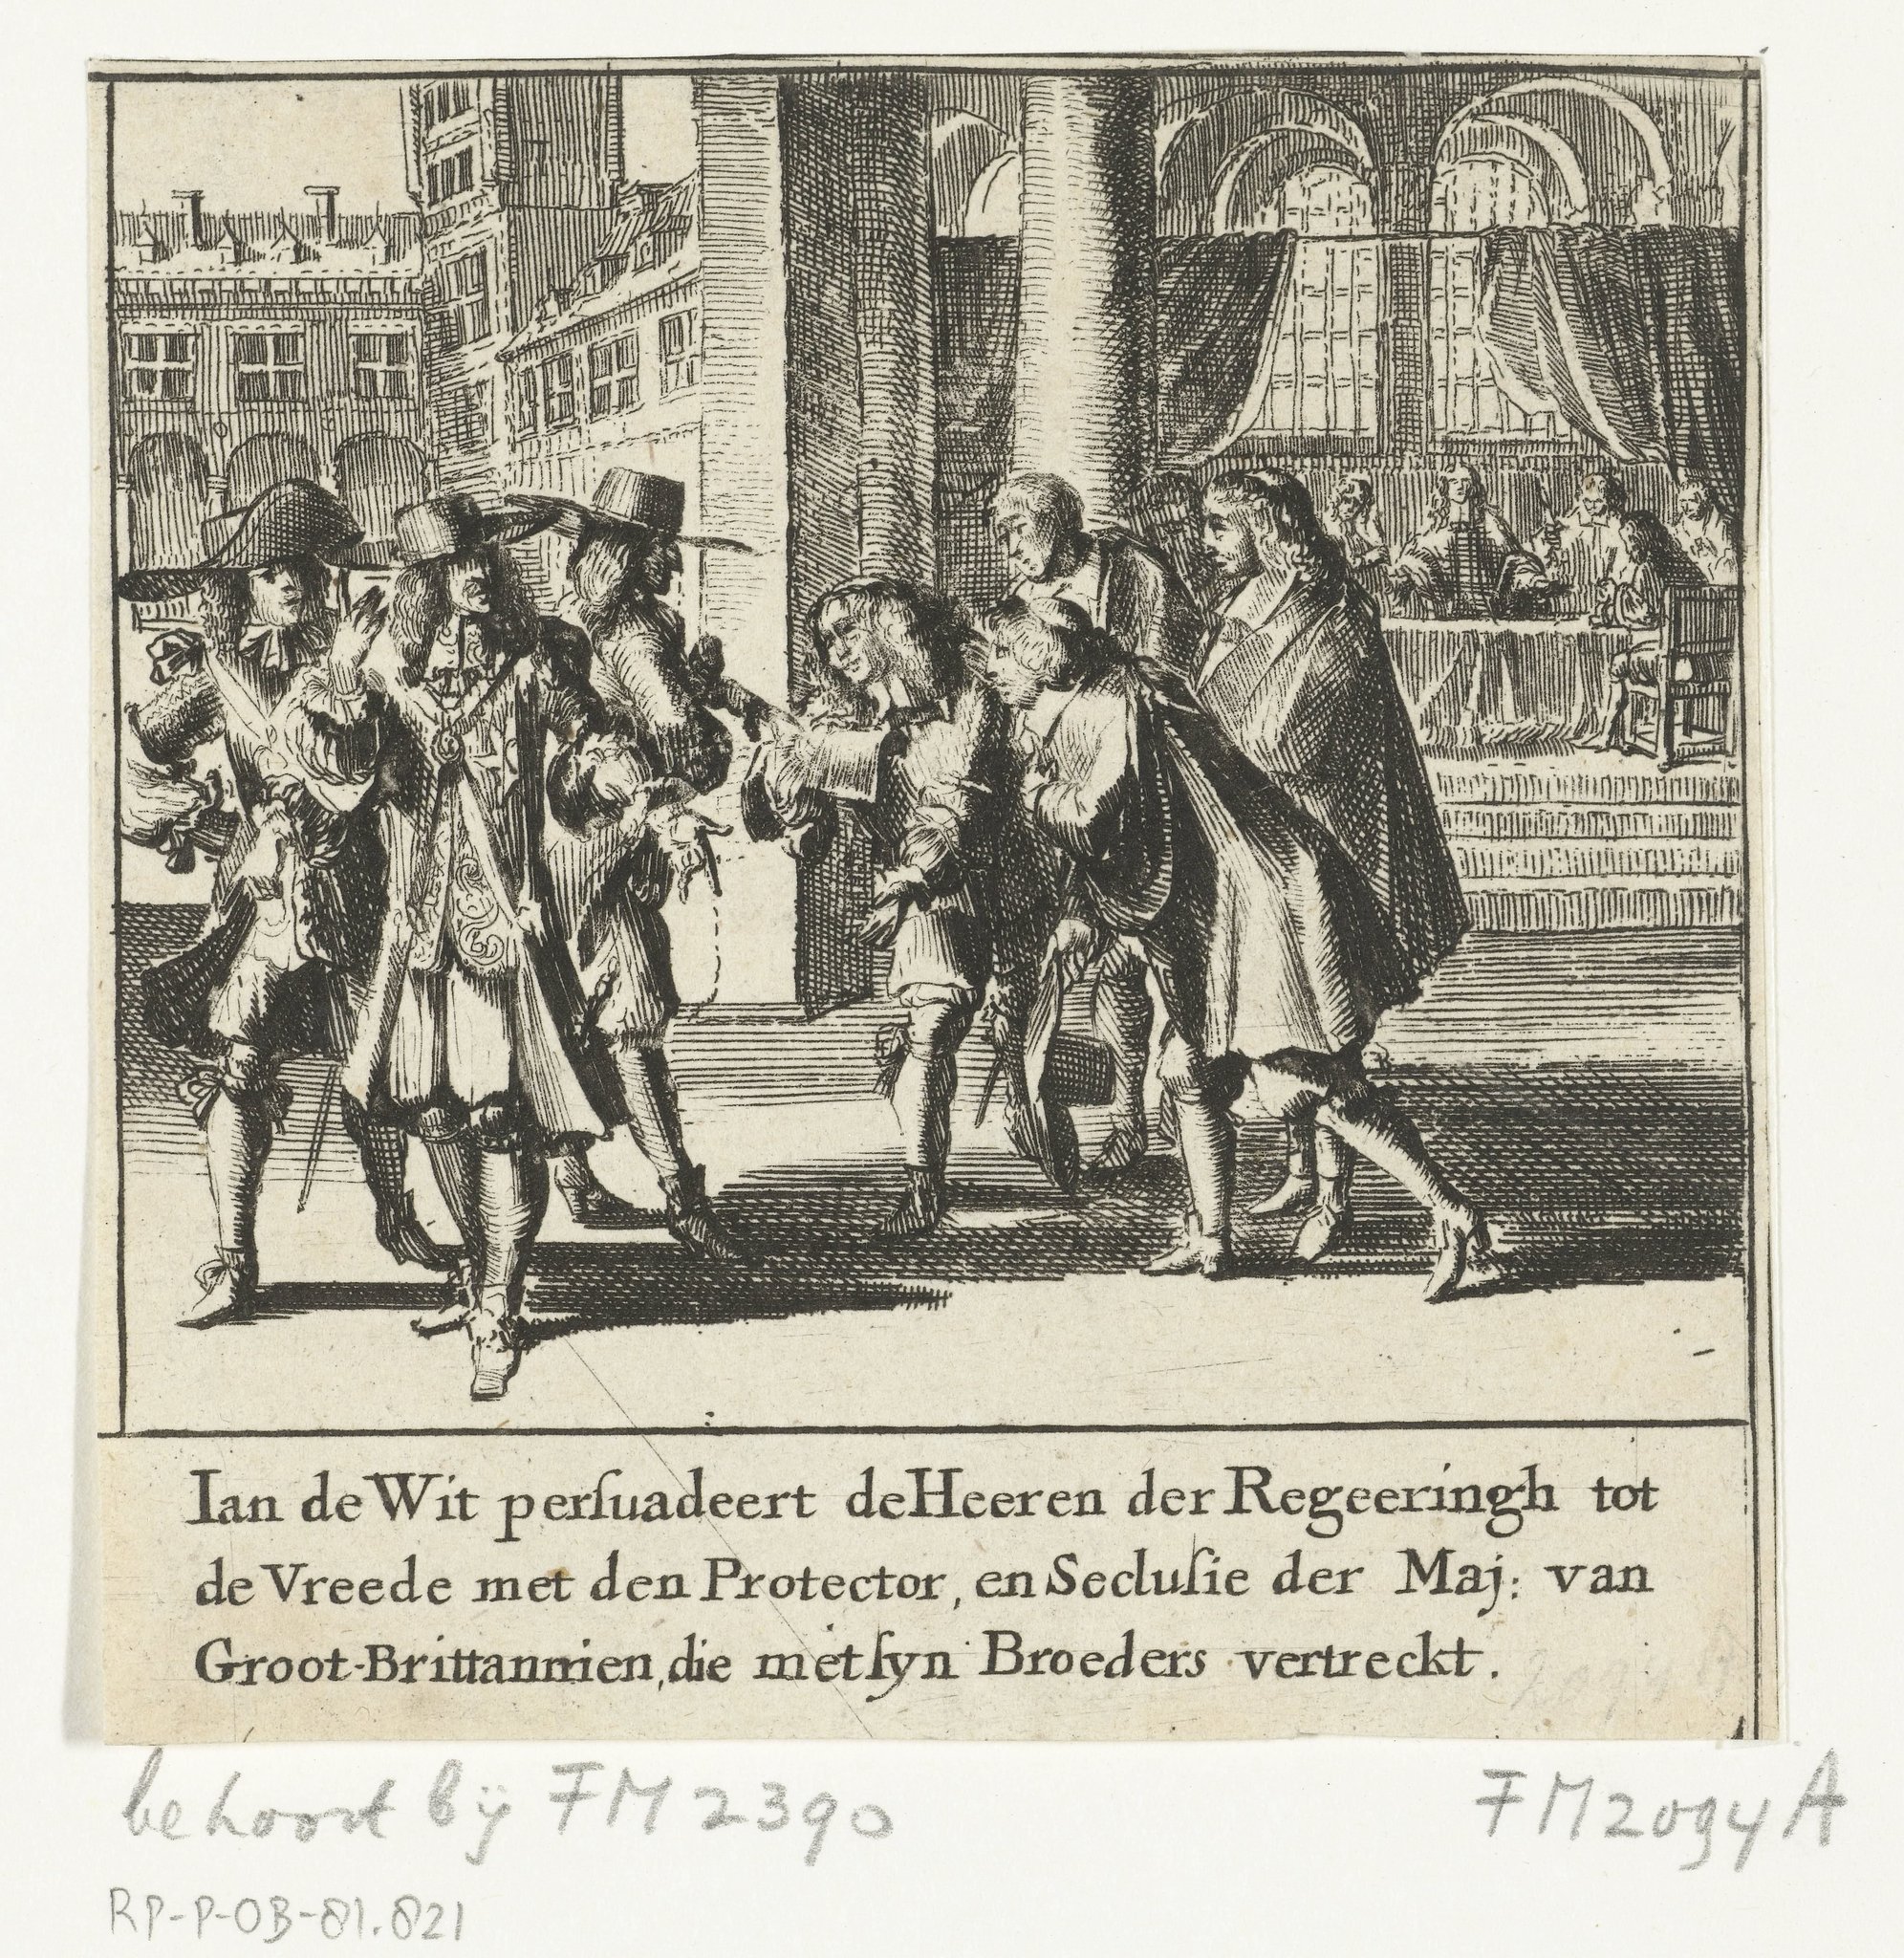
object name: print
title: Johan de Wit onderhandelt met de Engelsen over de vrede van Westminster en de Acte van Seclusie, 1654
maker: romeyn de hooghe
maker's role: draughtsman, goldsmith, painter, print maker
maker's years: 1645-1708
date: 1675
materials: paper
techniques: etching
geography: northern netherlands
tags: the hague, politician, johan de witt, karel ii (koning van engeland), peace negotiations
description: Johan de Wit onderhandelt met de Engelsen over de vrede van Westminster en de geheime clausule met de Acte van Seclusie, april 1654. Op de voorgrond vetrekt de Engelse koning Karel II met zijn broeders, op de achtergrond de vredesonderhandelingen te Westminster. Fragment van de grote prent over de gebroeders De Witt: Witten Wonder Spiegel (1675).